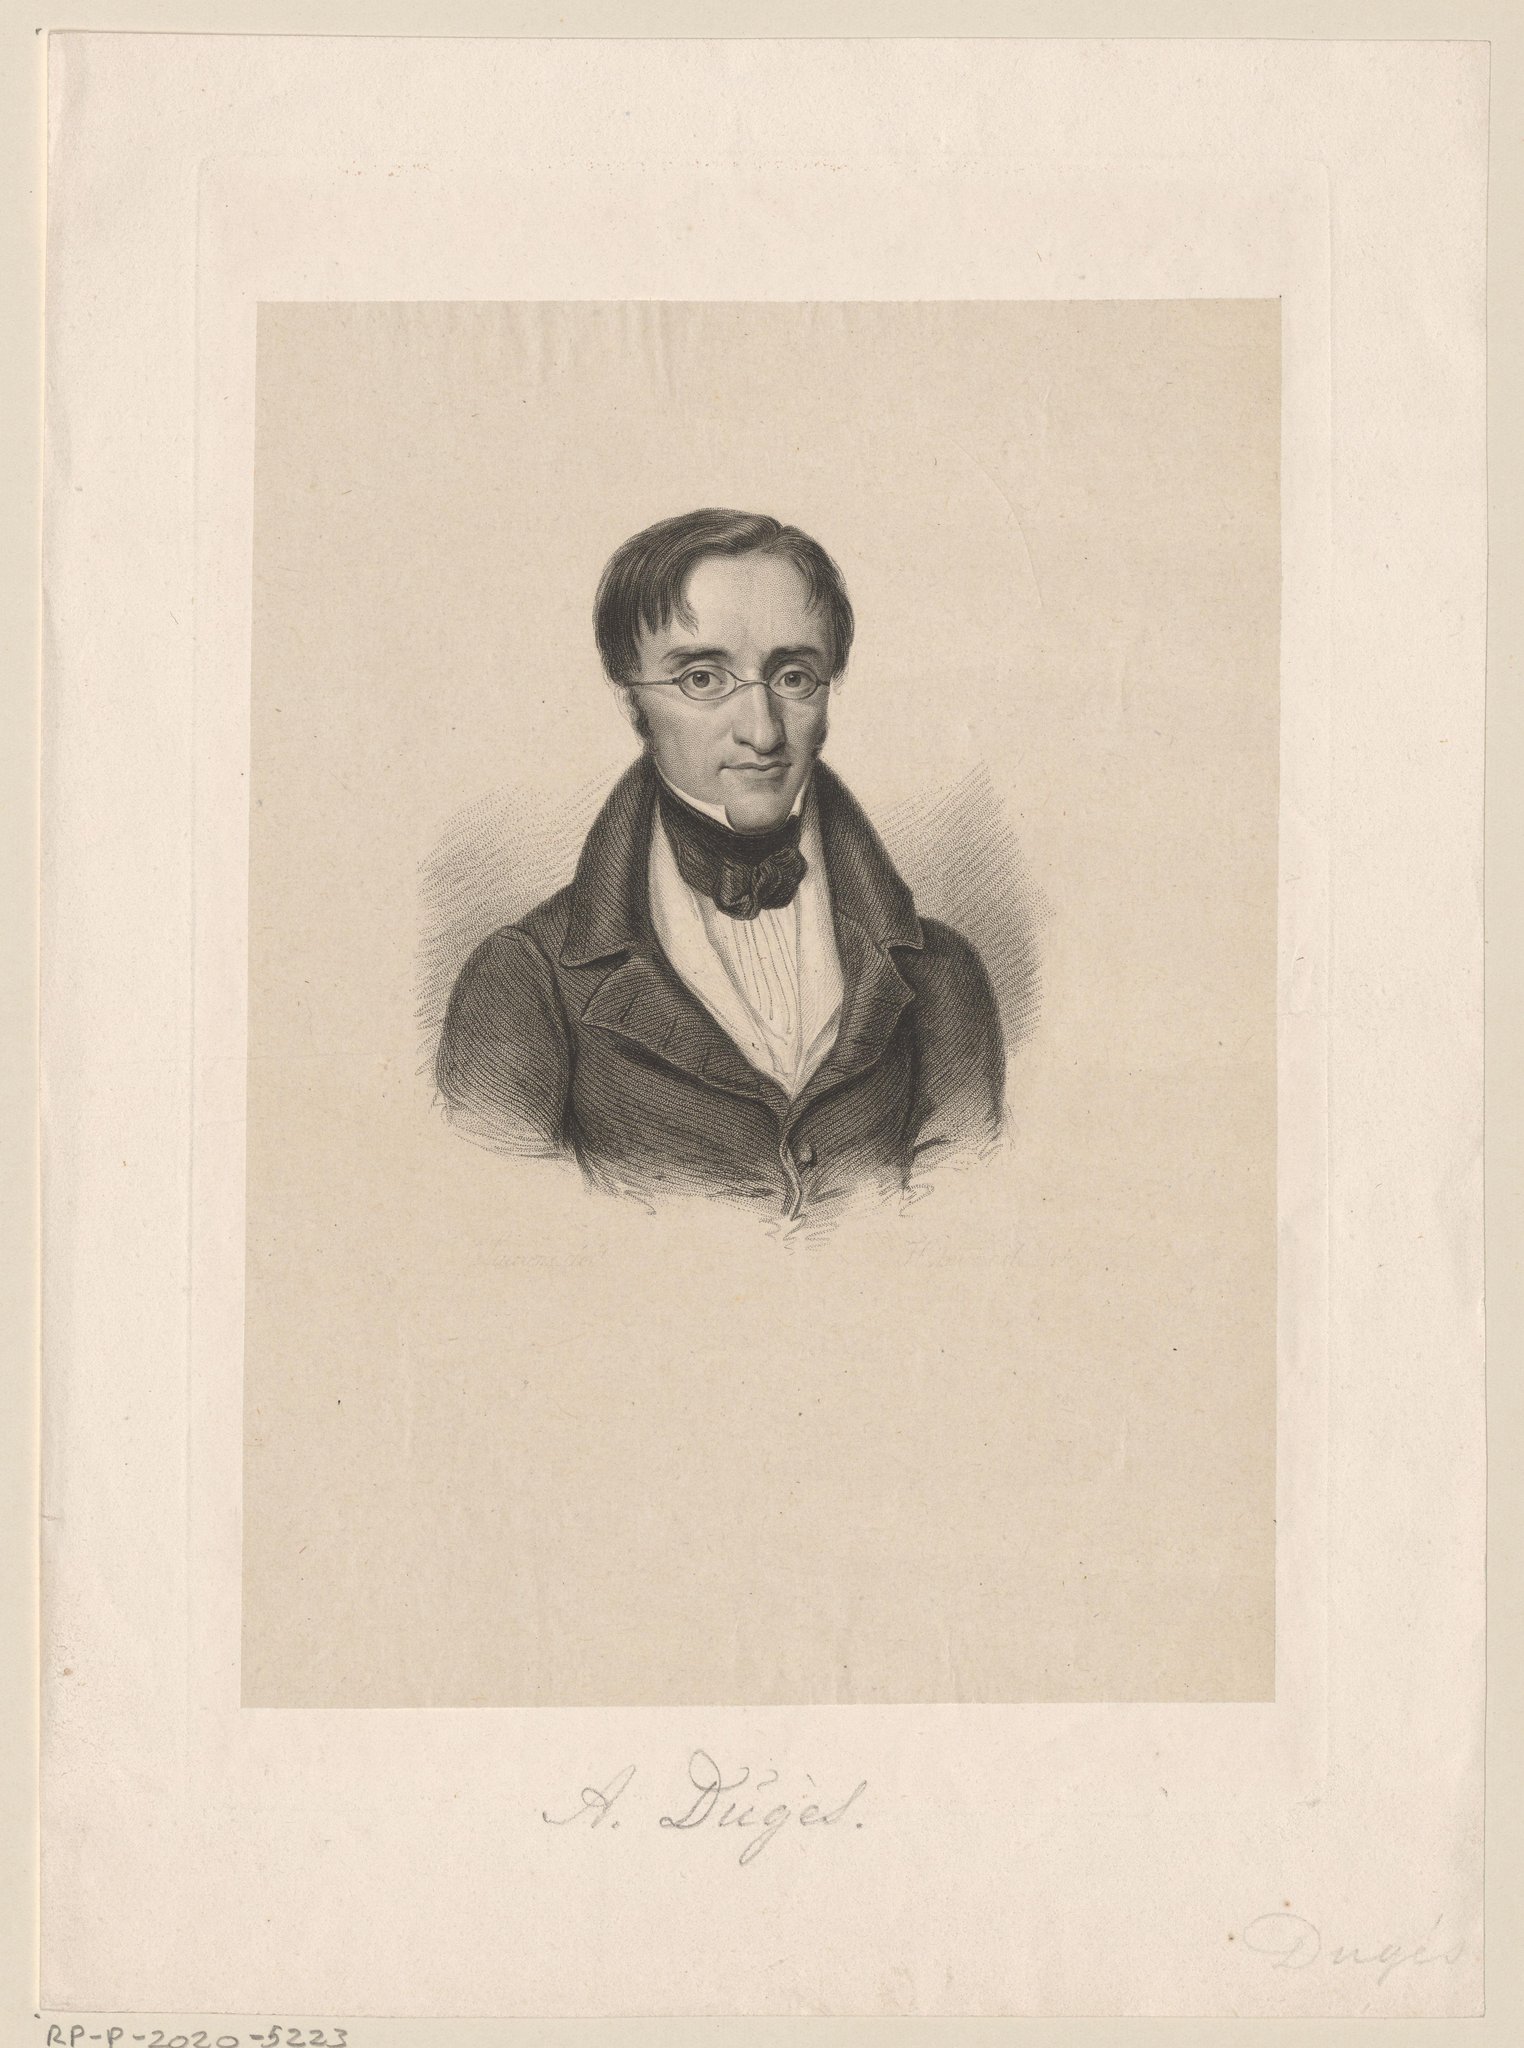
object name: print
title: Portret van Antoine Louis Dugès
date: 1820-1855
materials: paper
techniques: engraving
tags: gynaecology, obstetrics, historical persons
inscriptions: inscription: ‘A. D[u]gès’